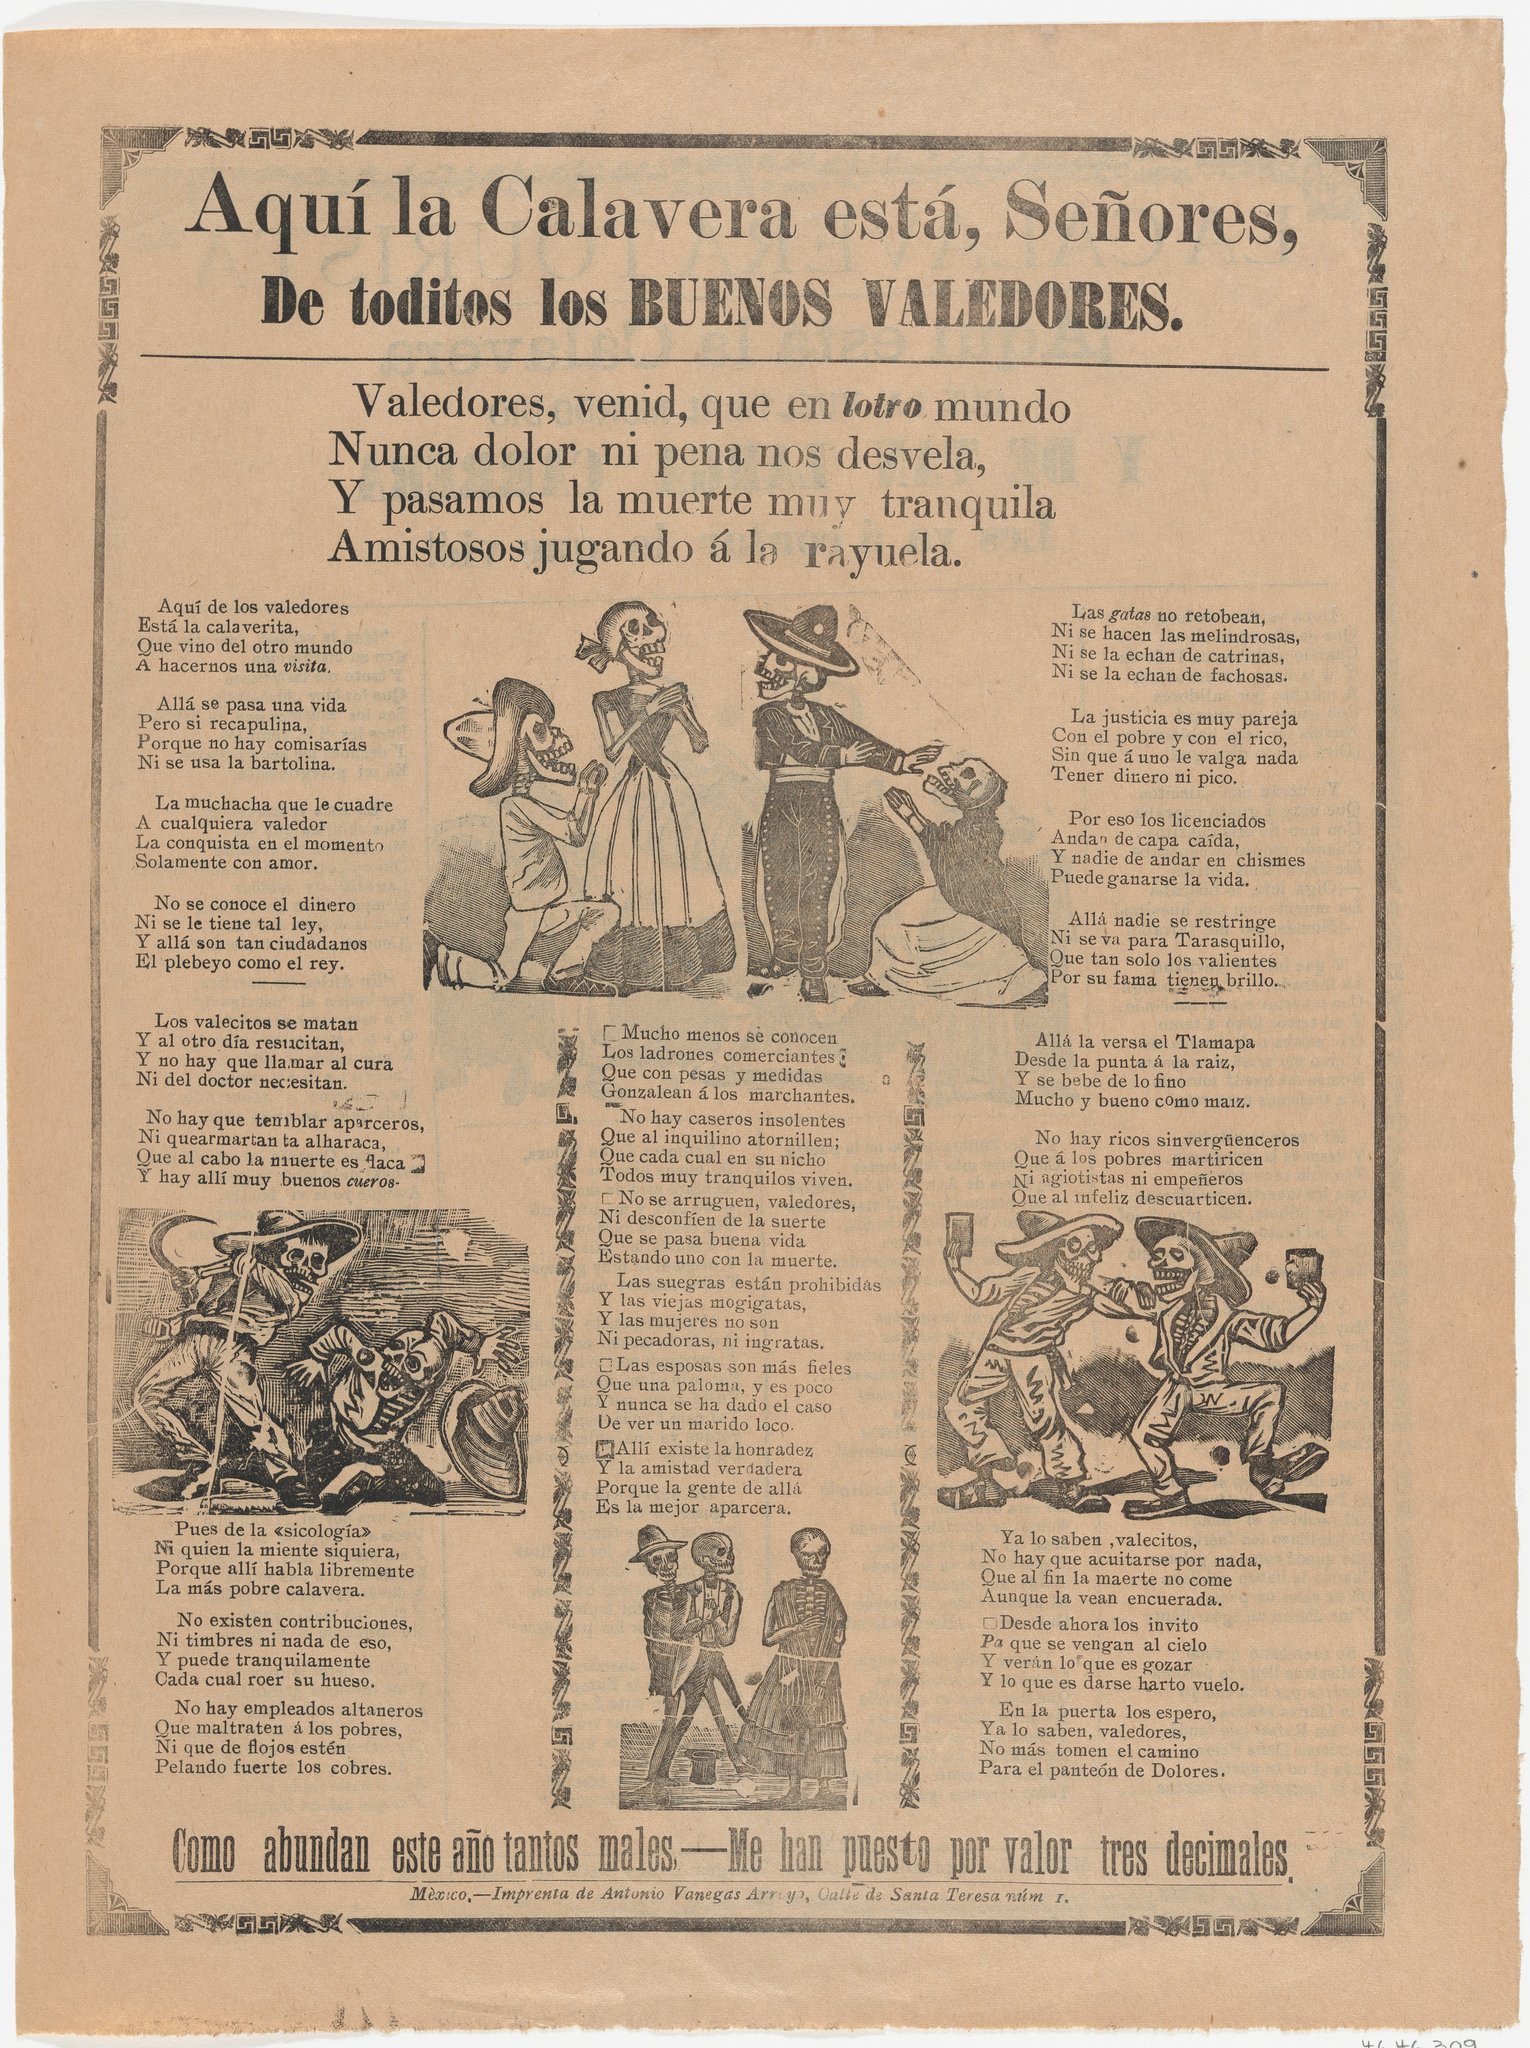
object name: print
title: Skeletons of the good defenders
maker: josé guadalupe posada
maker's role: artist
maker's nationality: mexican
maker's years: 1852-1913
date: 1900-1910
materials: metal, paper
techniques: engraving, letterpress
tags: skeletons